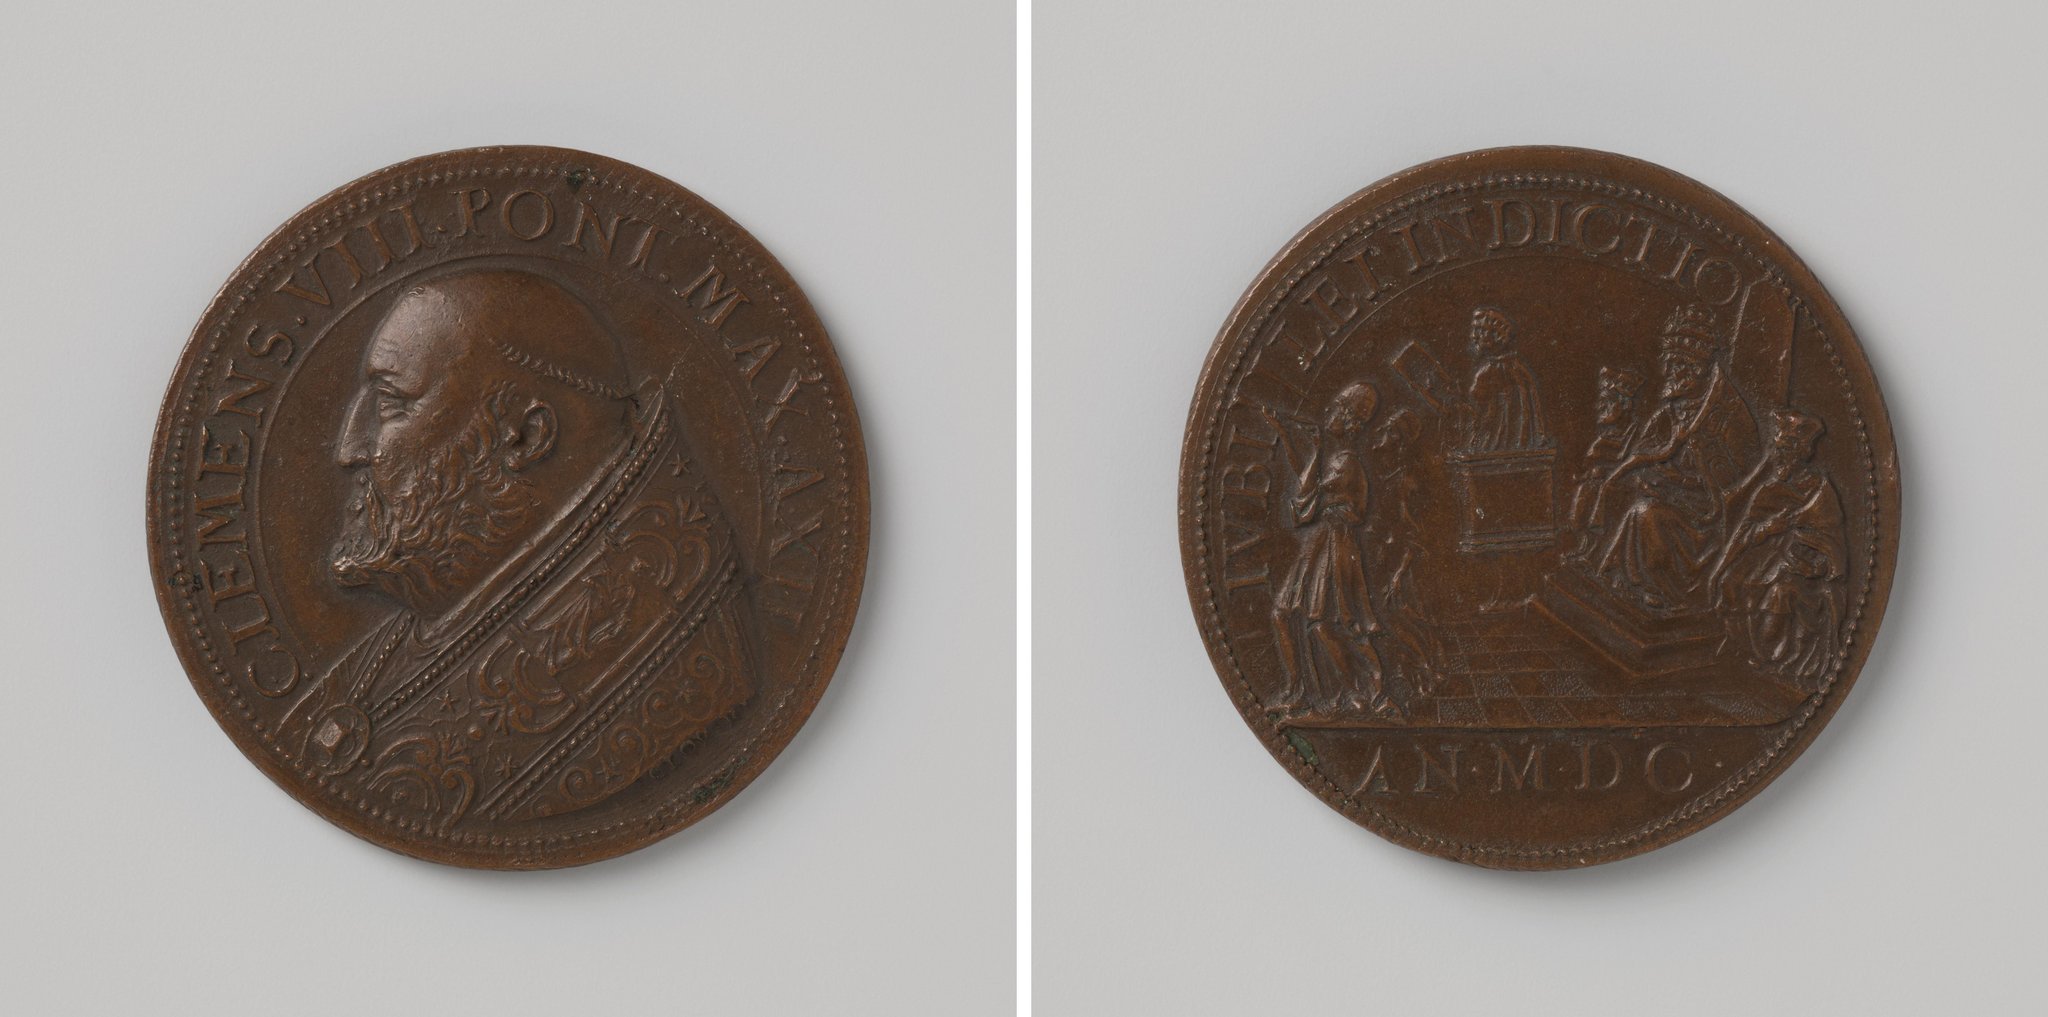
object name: history medal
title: Jubeljaar van paus Clemens VIII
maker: giorgio di antonio rancetti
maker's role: medailleur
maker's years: 1550-1611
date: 1600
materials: bronze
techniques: striking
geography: rome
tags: rome, clemens viii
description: Bronzen penning. Voorzijde: borststuk man binnen omschriftauselijke tiara gezeten op troon, aan weerszijden daarvan kardinalen, voor hem twee mannen met trompet, in midden man die staande op preekstoel uit boek leest binnen omschrift